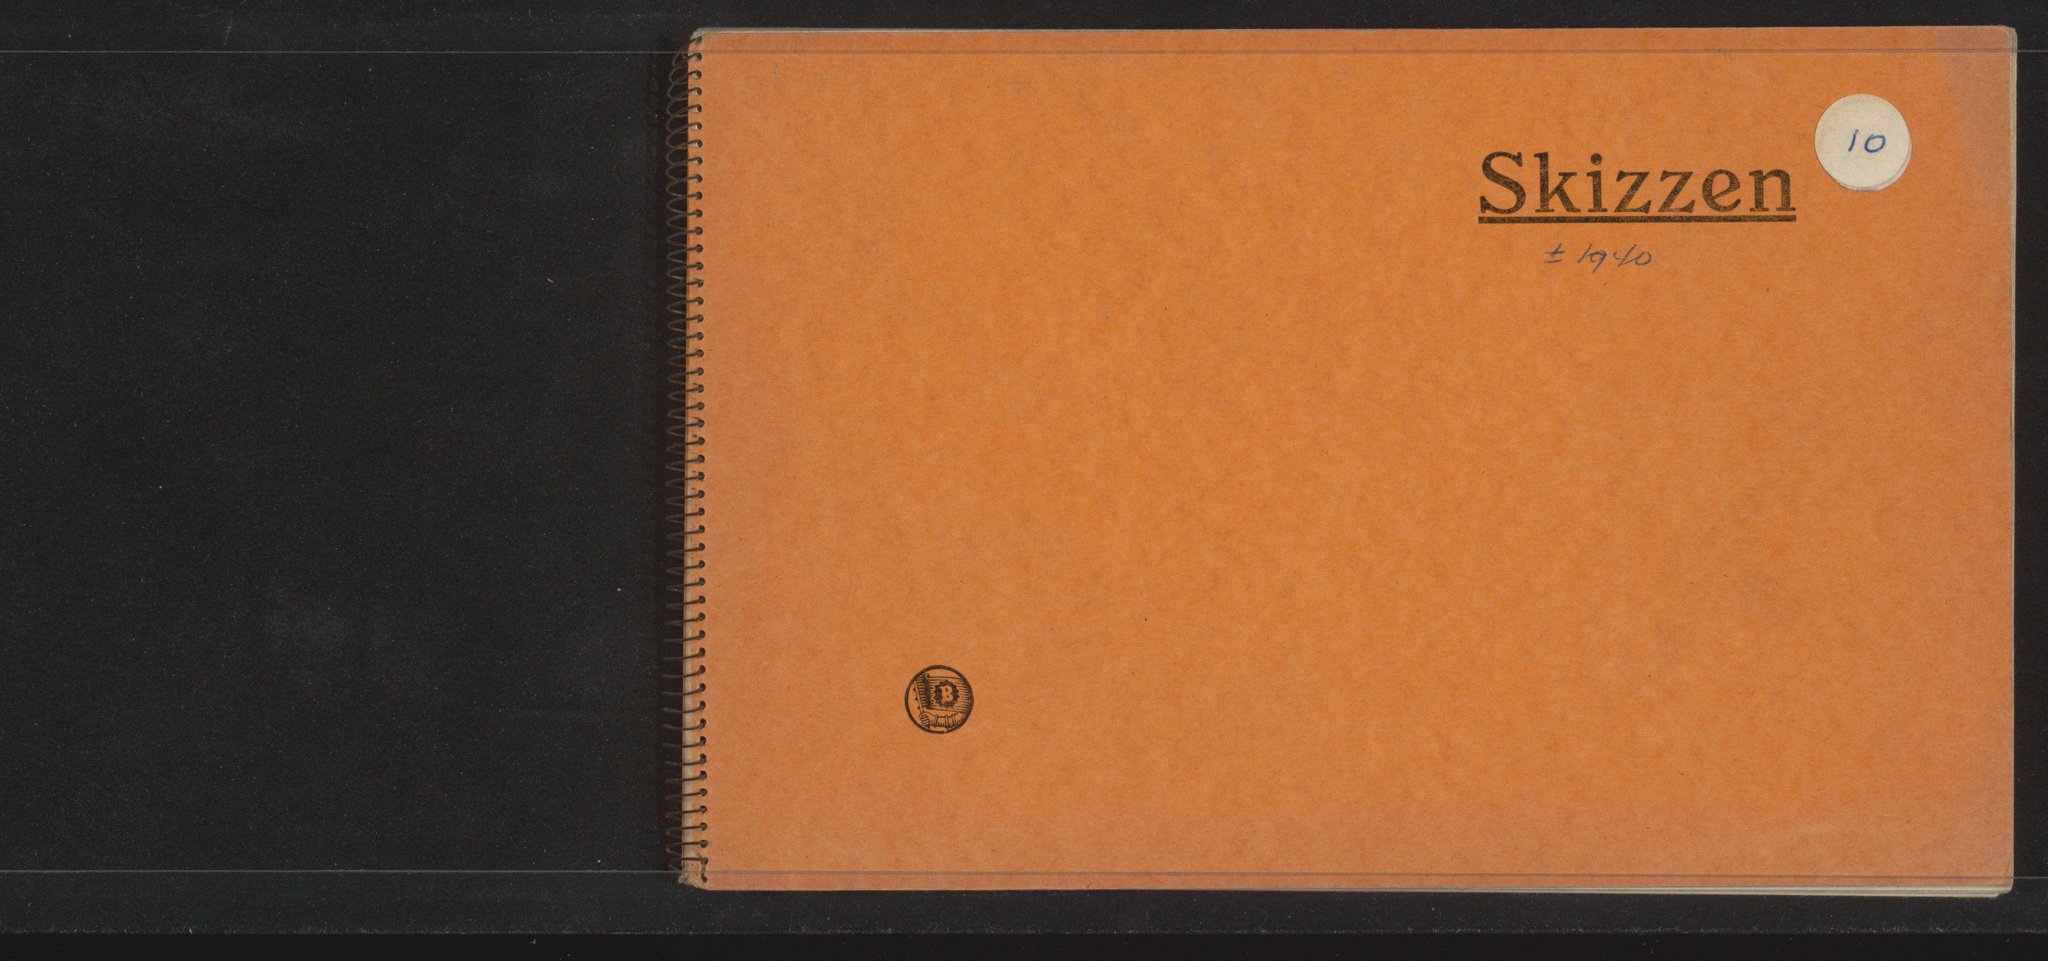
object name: sketchbook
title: Schetsboek met 25 bladen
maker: carel adolph lion cachet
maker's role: draughtsman, print maker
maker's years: 1864-1945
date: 1935-1940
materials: cardboard, chalk, ink, paper, pencil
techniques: brush, pen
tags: adult woman, doves, pigeons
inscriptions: collector's mark: Lugt 2228a, annotation: ‘schetsen van mevr LionCachet-Cordes’, factory mark: ‘CEBE-Spirale/ D.R.P. Nr. 401073/ S 6315’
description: Schetsboek bestaande uit 25 bladen met voornamelijk portretten van Joanna Hermine Lion Cachet-Cordes, echtgenote van de kunstenaar, figuurstudies en duiven.